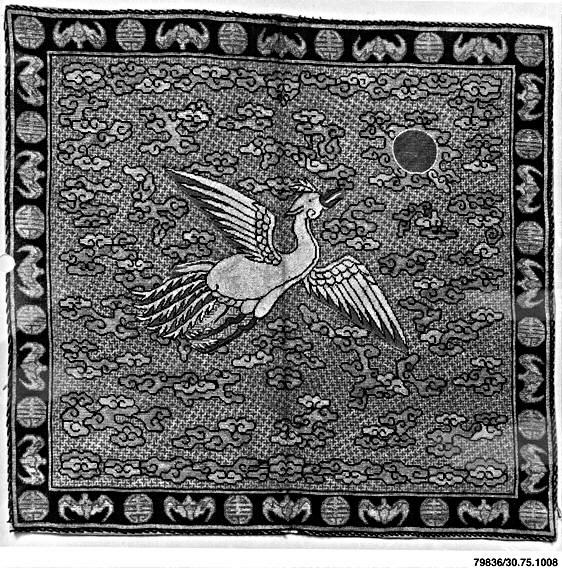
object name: rank badge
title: Rank Badge with Silver Pheasant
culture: chinese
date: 1801-1900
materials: metal thread, silk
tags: bats,pheasants